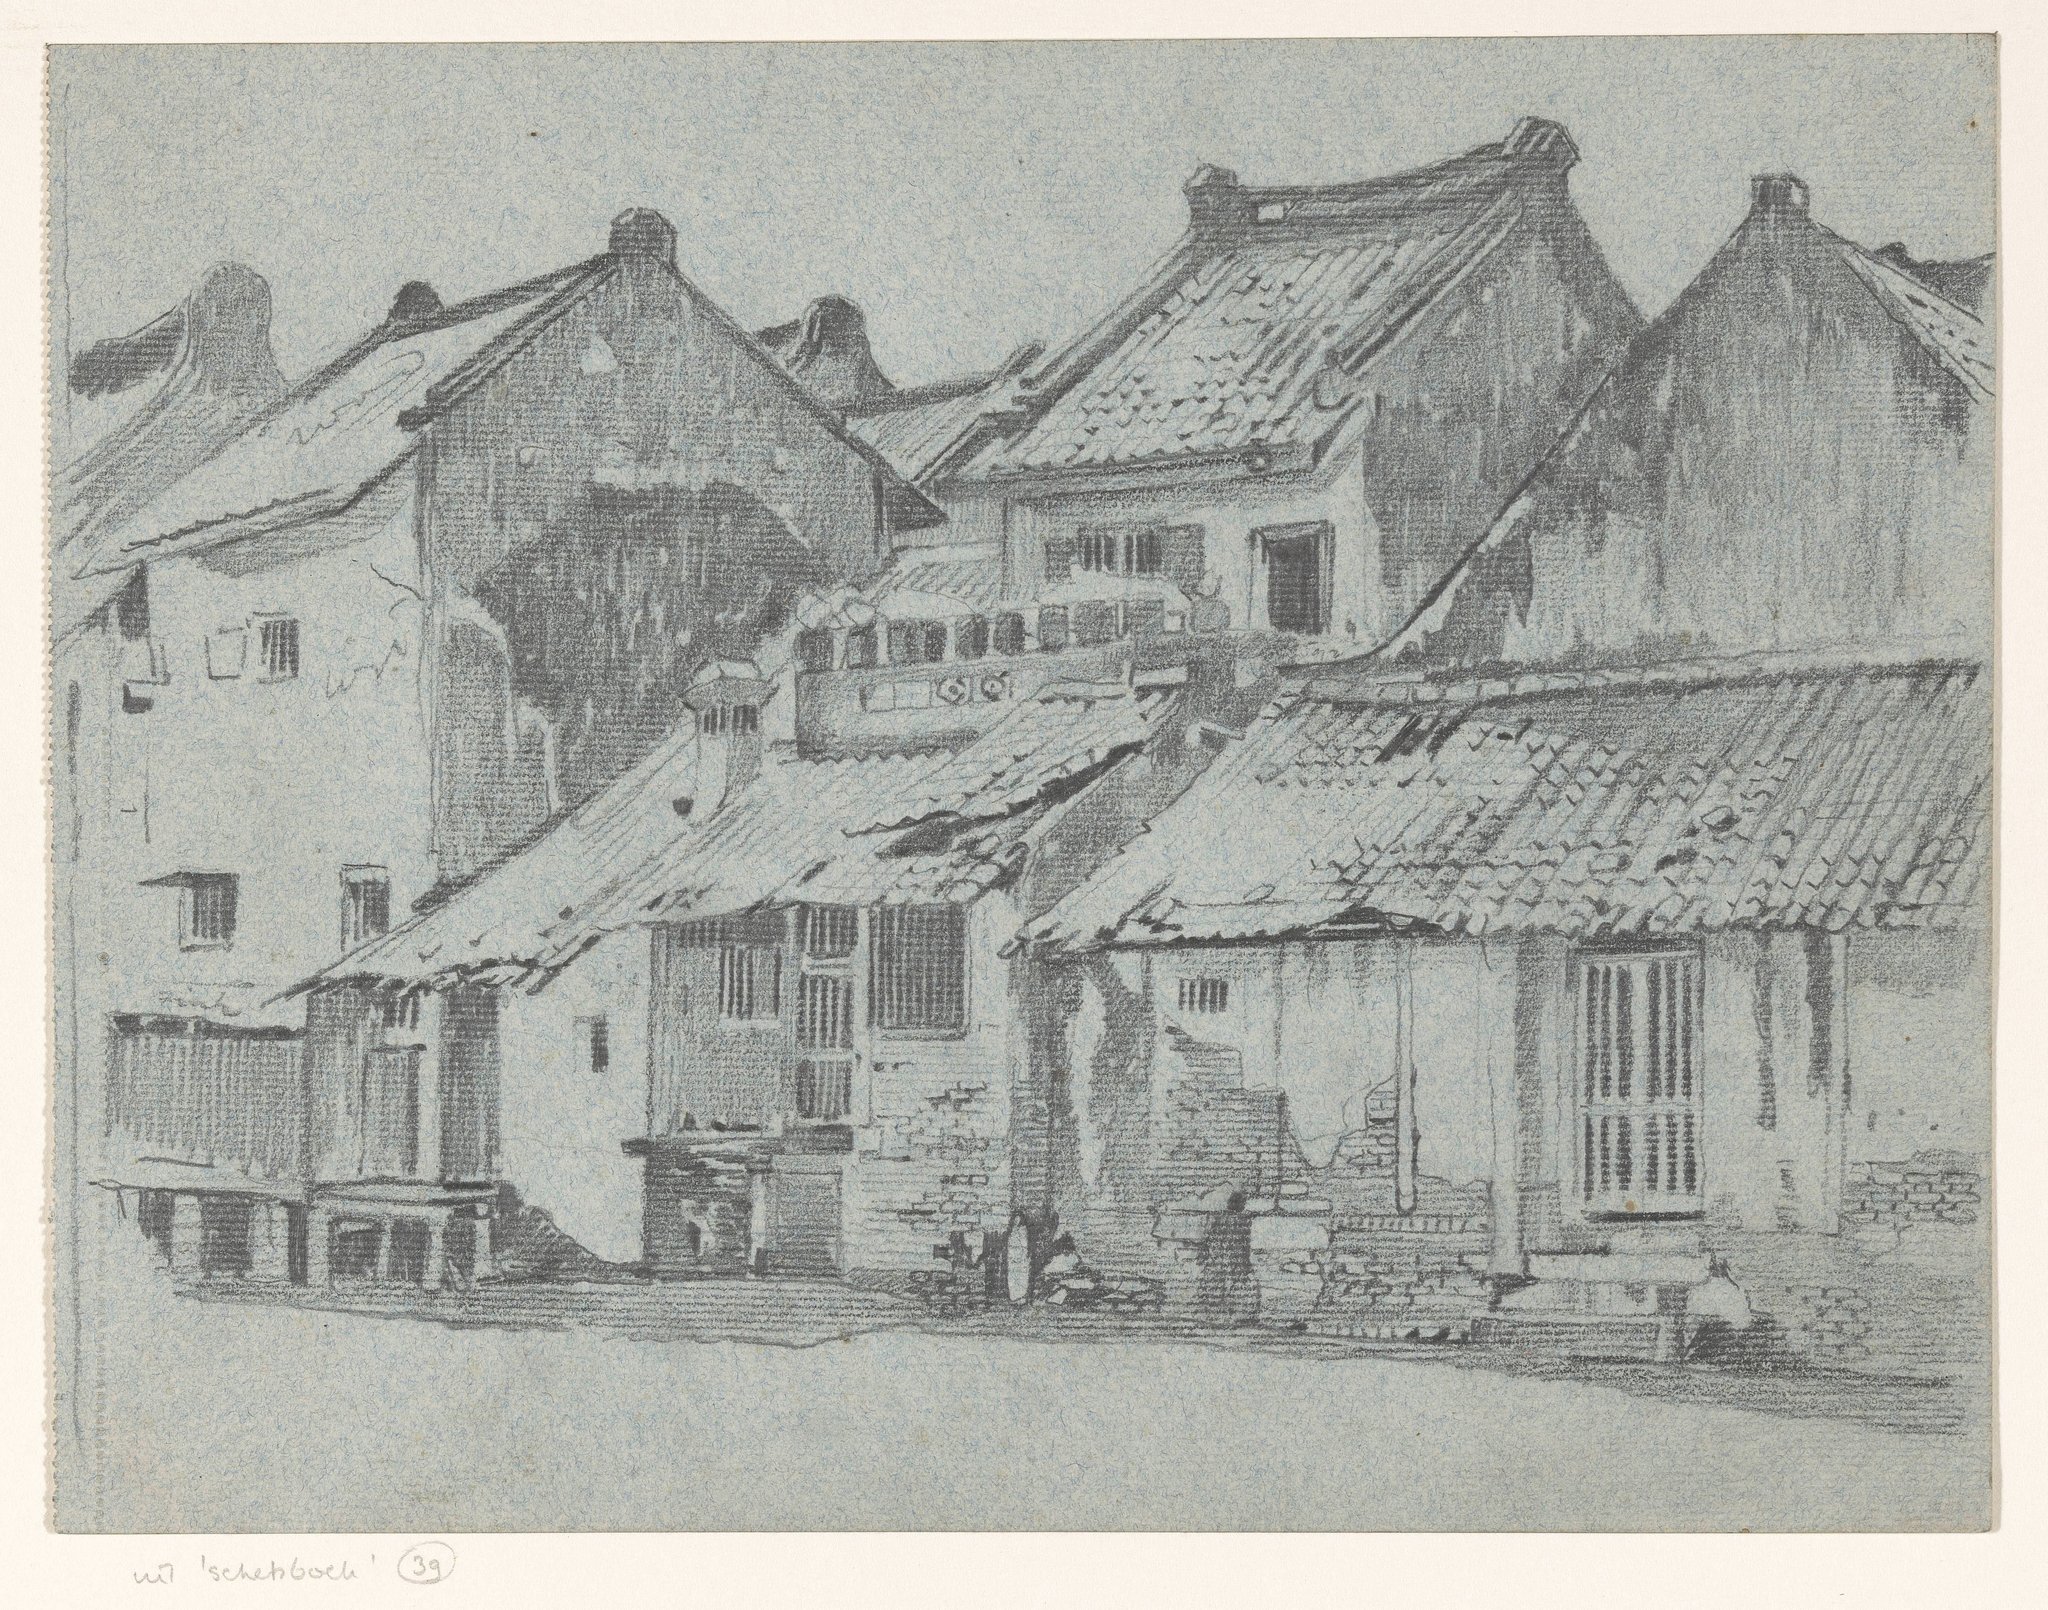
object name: drawing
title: Achtergevels van woningen aan een rivier in Batavia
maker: willem witsen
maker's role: draughtsman, painter, print maker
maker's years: 1860-1923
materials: paper, pencil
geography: batavia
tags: urban housing, canals, waters (in city), batavia